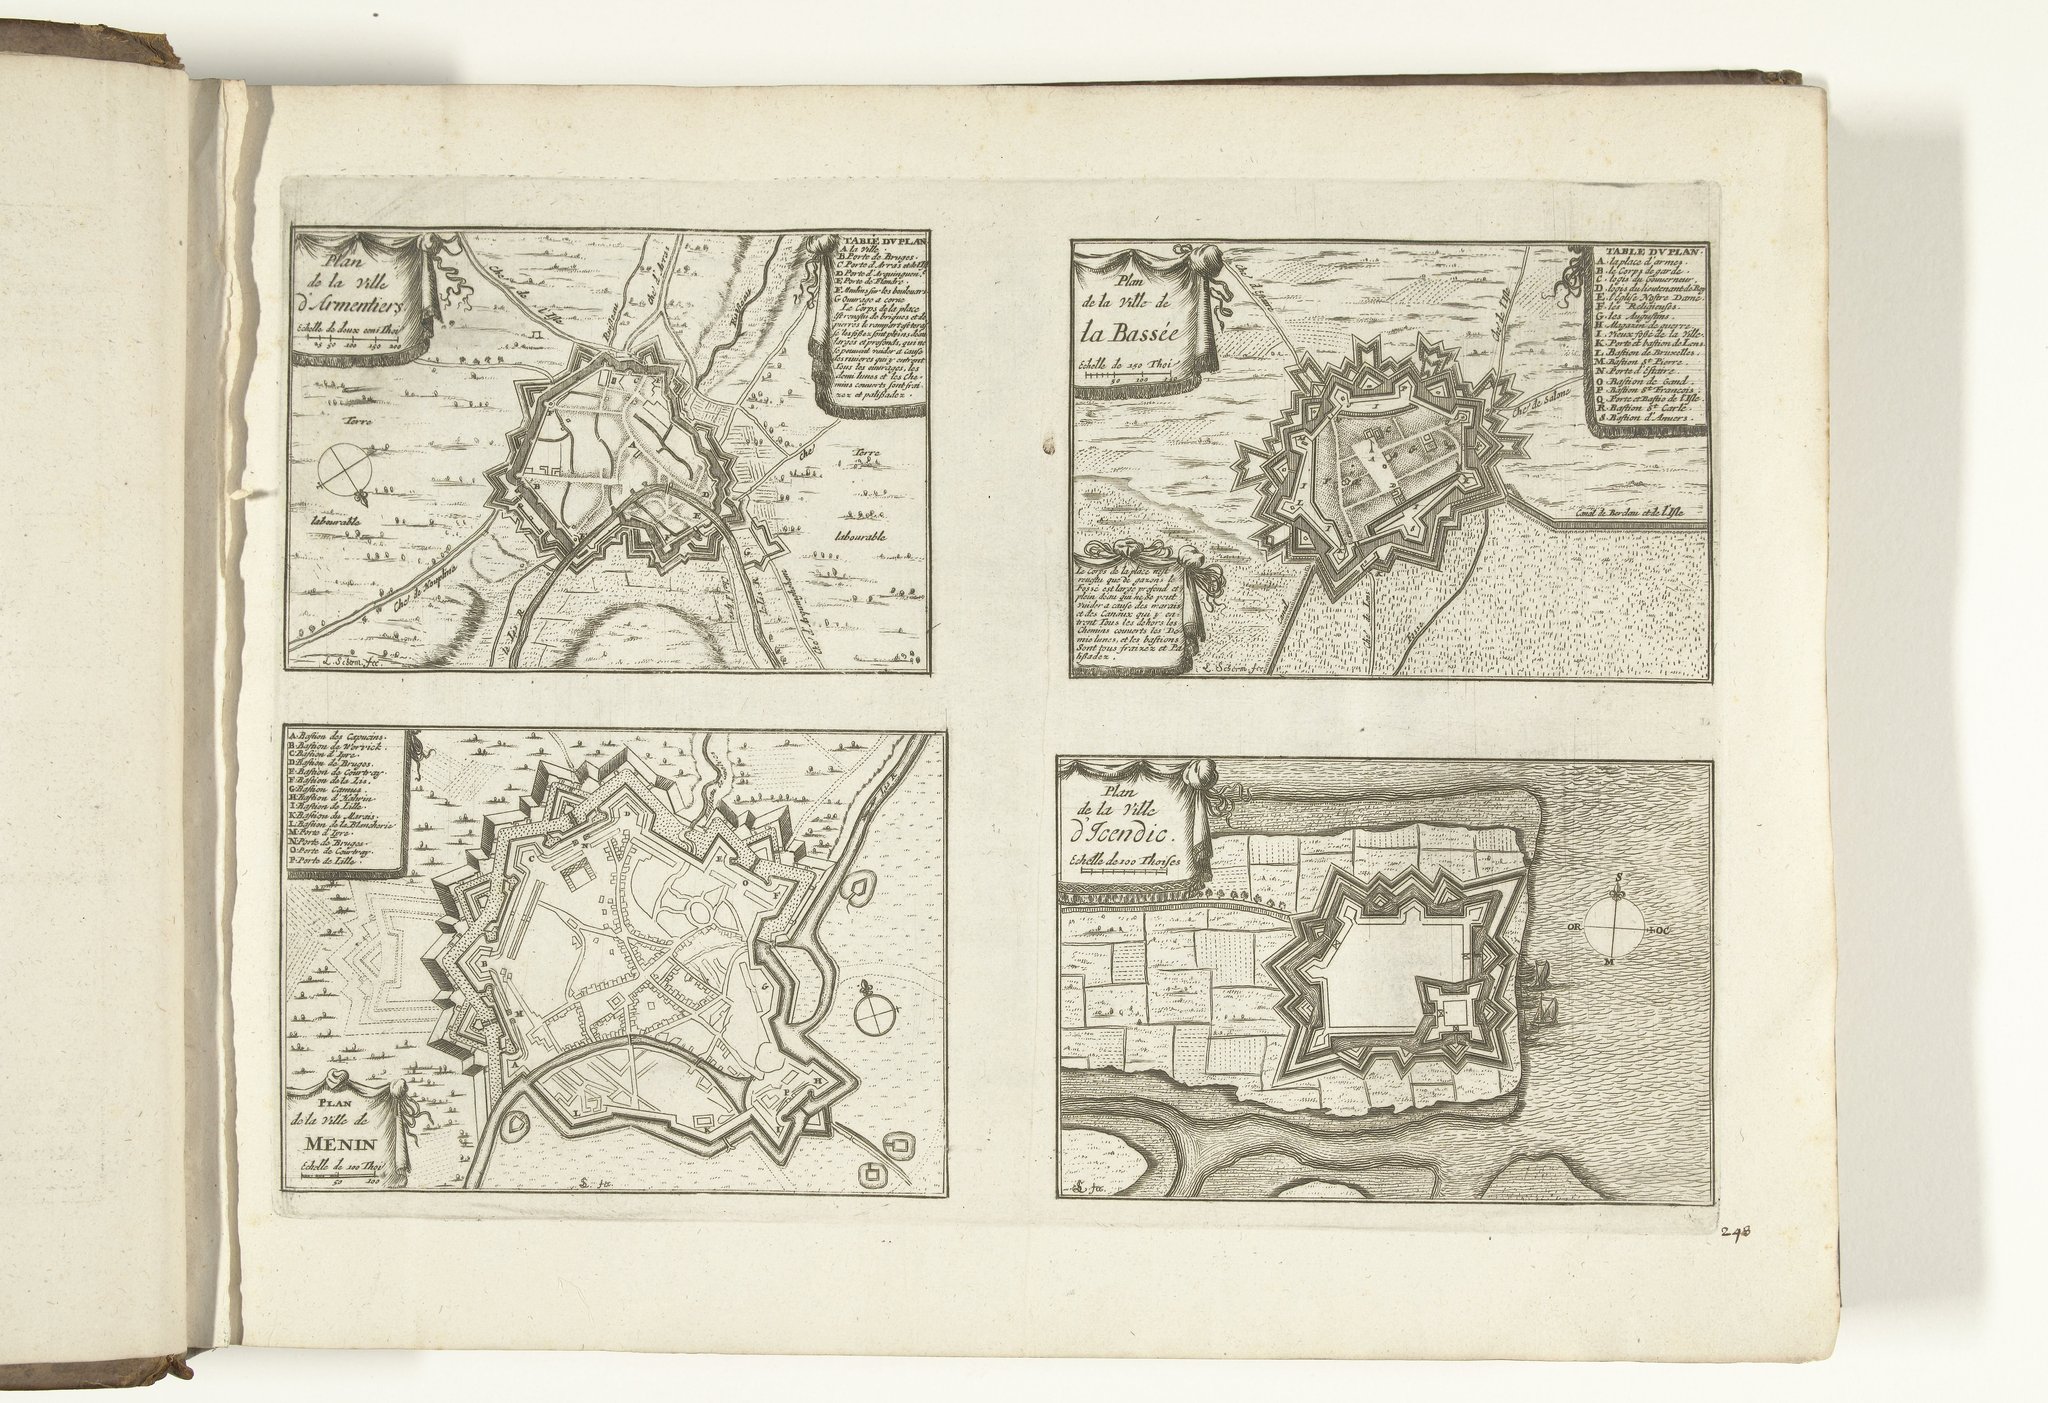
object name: print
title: Armentiers / la Bassée / Menin / Icendic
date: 1726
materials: paper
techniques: engraving, etching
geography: northern netherlands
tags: fortress, maps of cities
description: Blad met vier plattegronden van de versterkingen om de plaatsen Armentieres, La Bassée, Menin en IJzendijke. Plaat nr. 243 in deel XI van het prentwerk: Les Forces de l'Europe, Asie, Afrique et Amerique ... Comme aussi les Cartes des Côtes de France et d'Espagne uit 1726, dit tweede deel met 271 met de hand genummerde platen van vermaarde sterke steden en vestingen in het kader van de Spaanse Successieoorlog 1701-1713. Voor het merendeel zijn deze platen gekopieerd naar de anonieme Franse platen van vermaarde sterke steden en vestingen: in Les forces de l'Europe en in: Le theatre de la guerre, dans les Pays-Bas, beide oorspronkelijk uitgegeven door Nicolas de Fer te Parijs (1693-1697) in het kader van de Negenjarige Oorlog. Titels en opschriften in het Frans. Rechtsonder sporen van het weggepolijste nummer: 80.